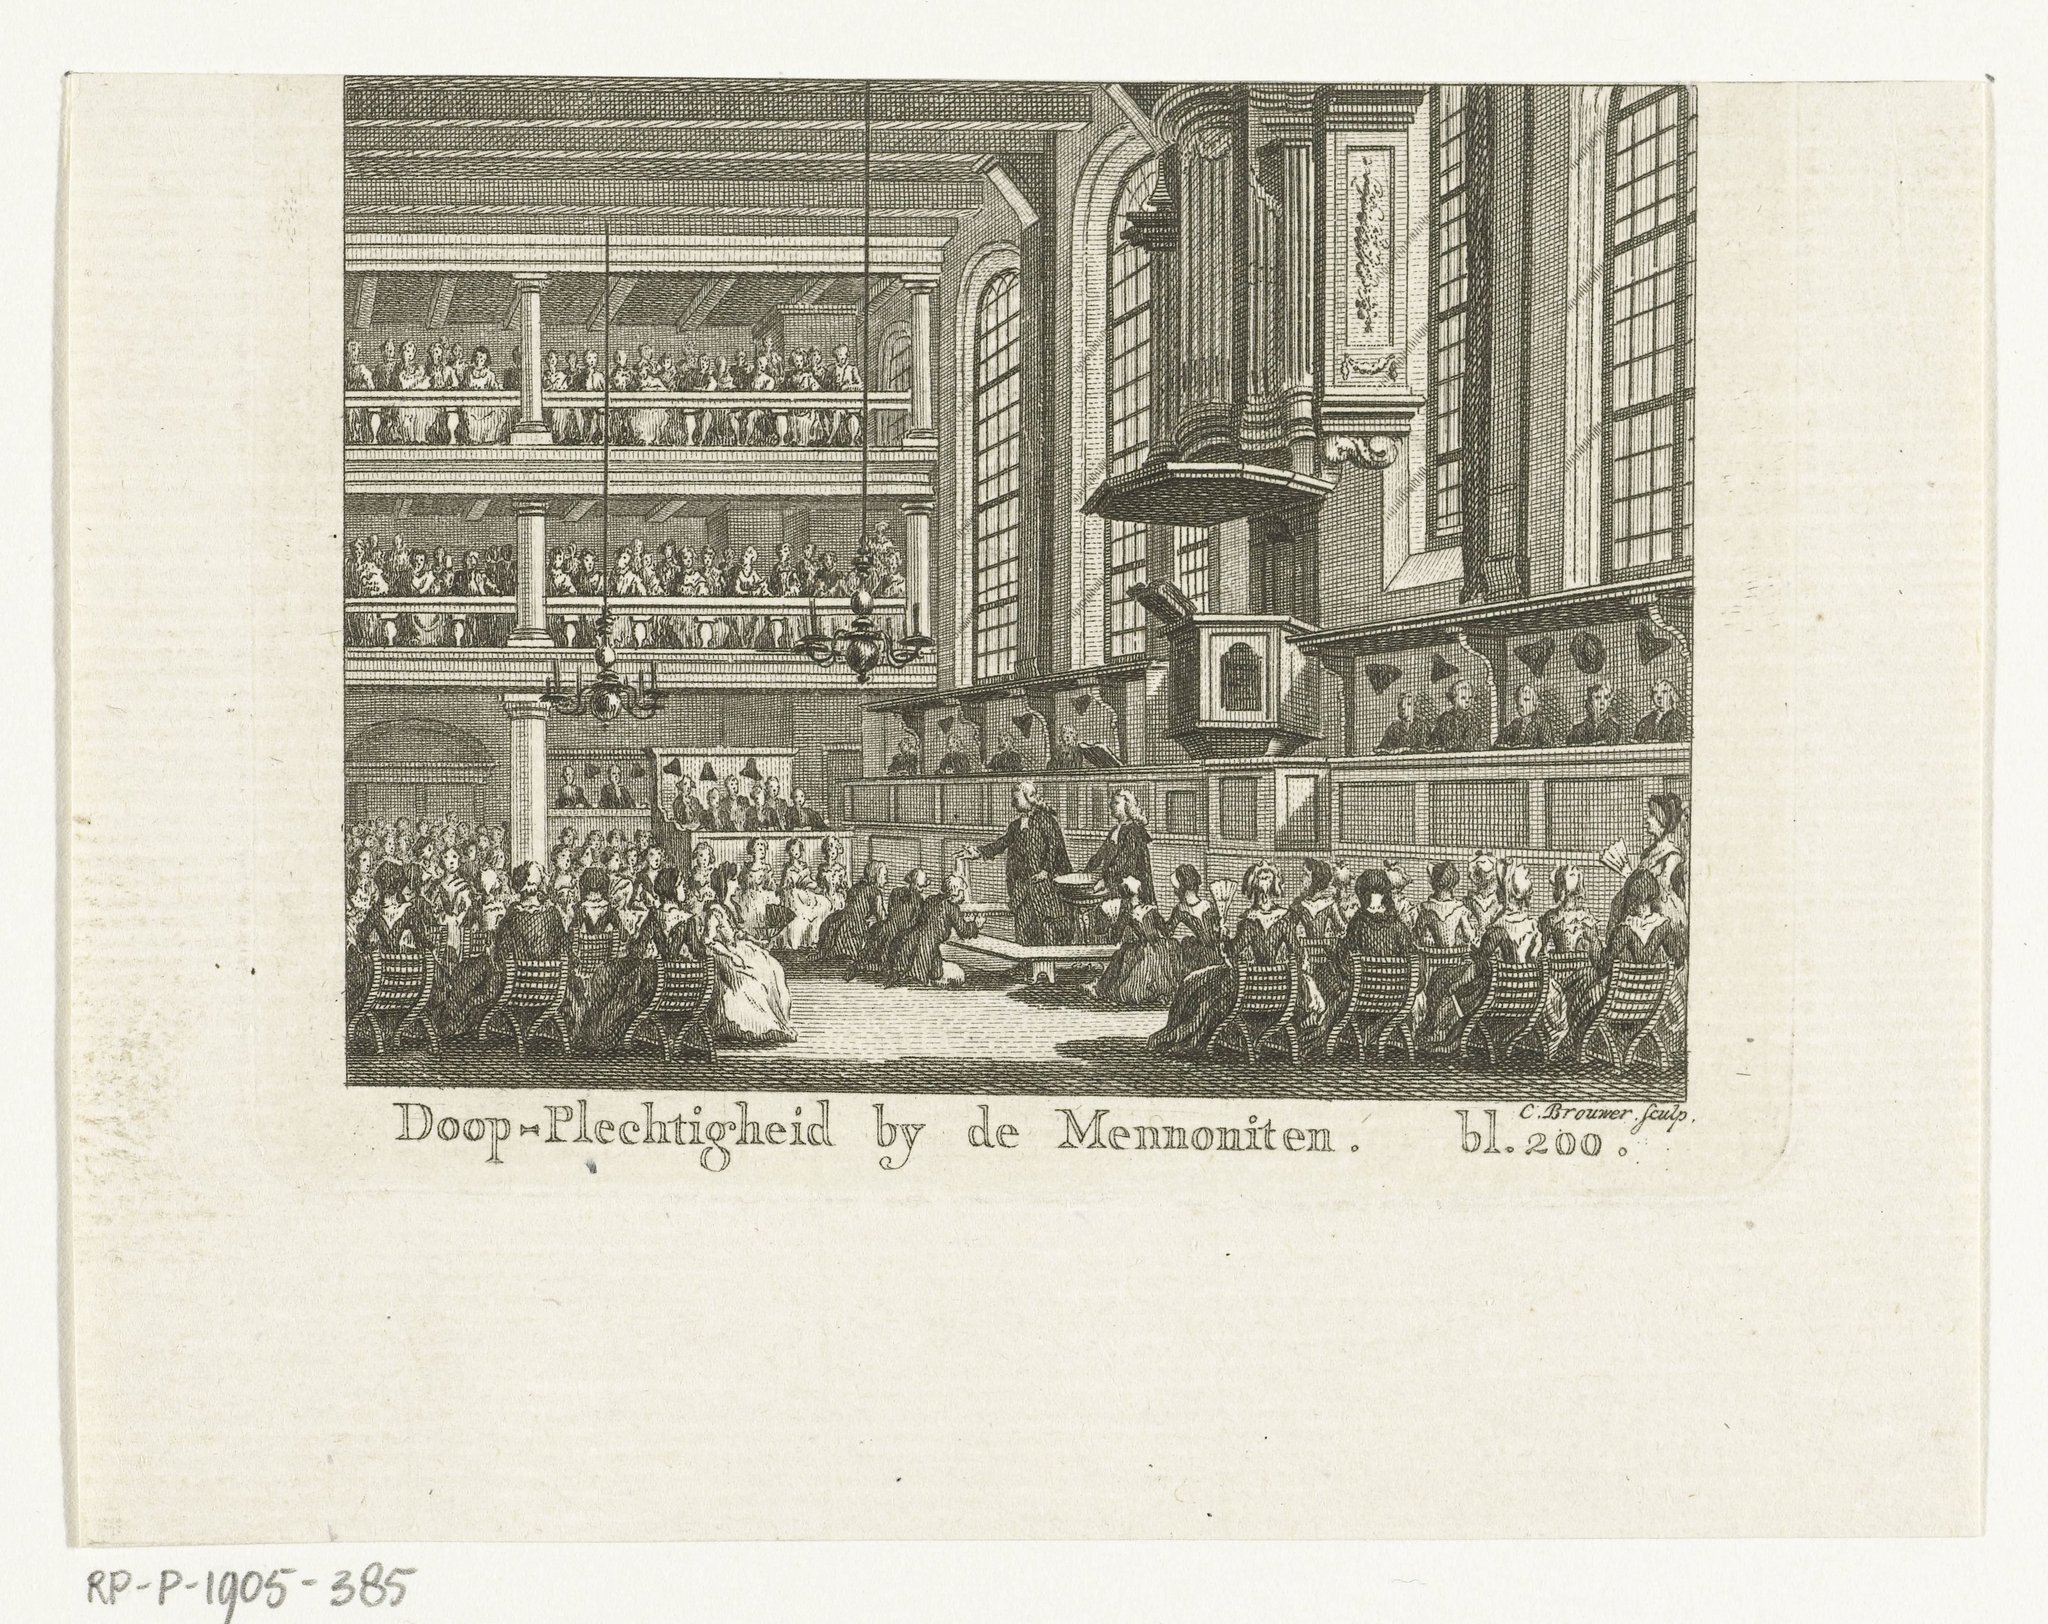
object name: print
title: Doop in de Doopsgezinde Kerk Bij 't Lam te Amsterdam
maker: cornelis brouwer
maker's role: print maker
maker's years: 1731-1803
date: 1780-1790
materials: paper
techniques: etching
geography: netherlands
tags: baptism ~ protestant service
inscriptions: collector's mark: Lugt 2228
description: Het interieur van de Doopsgezinde kerk Bij 't Lam tijdens de bediening van de doop. Boven de preekstoel het in 1777 voltooide Strumphler-orgel.